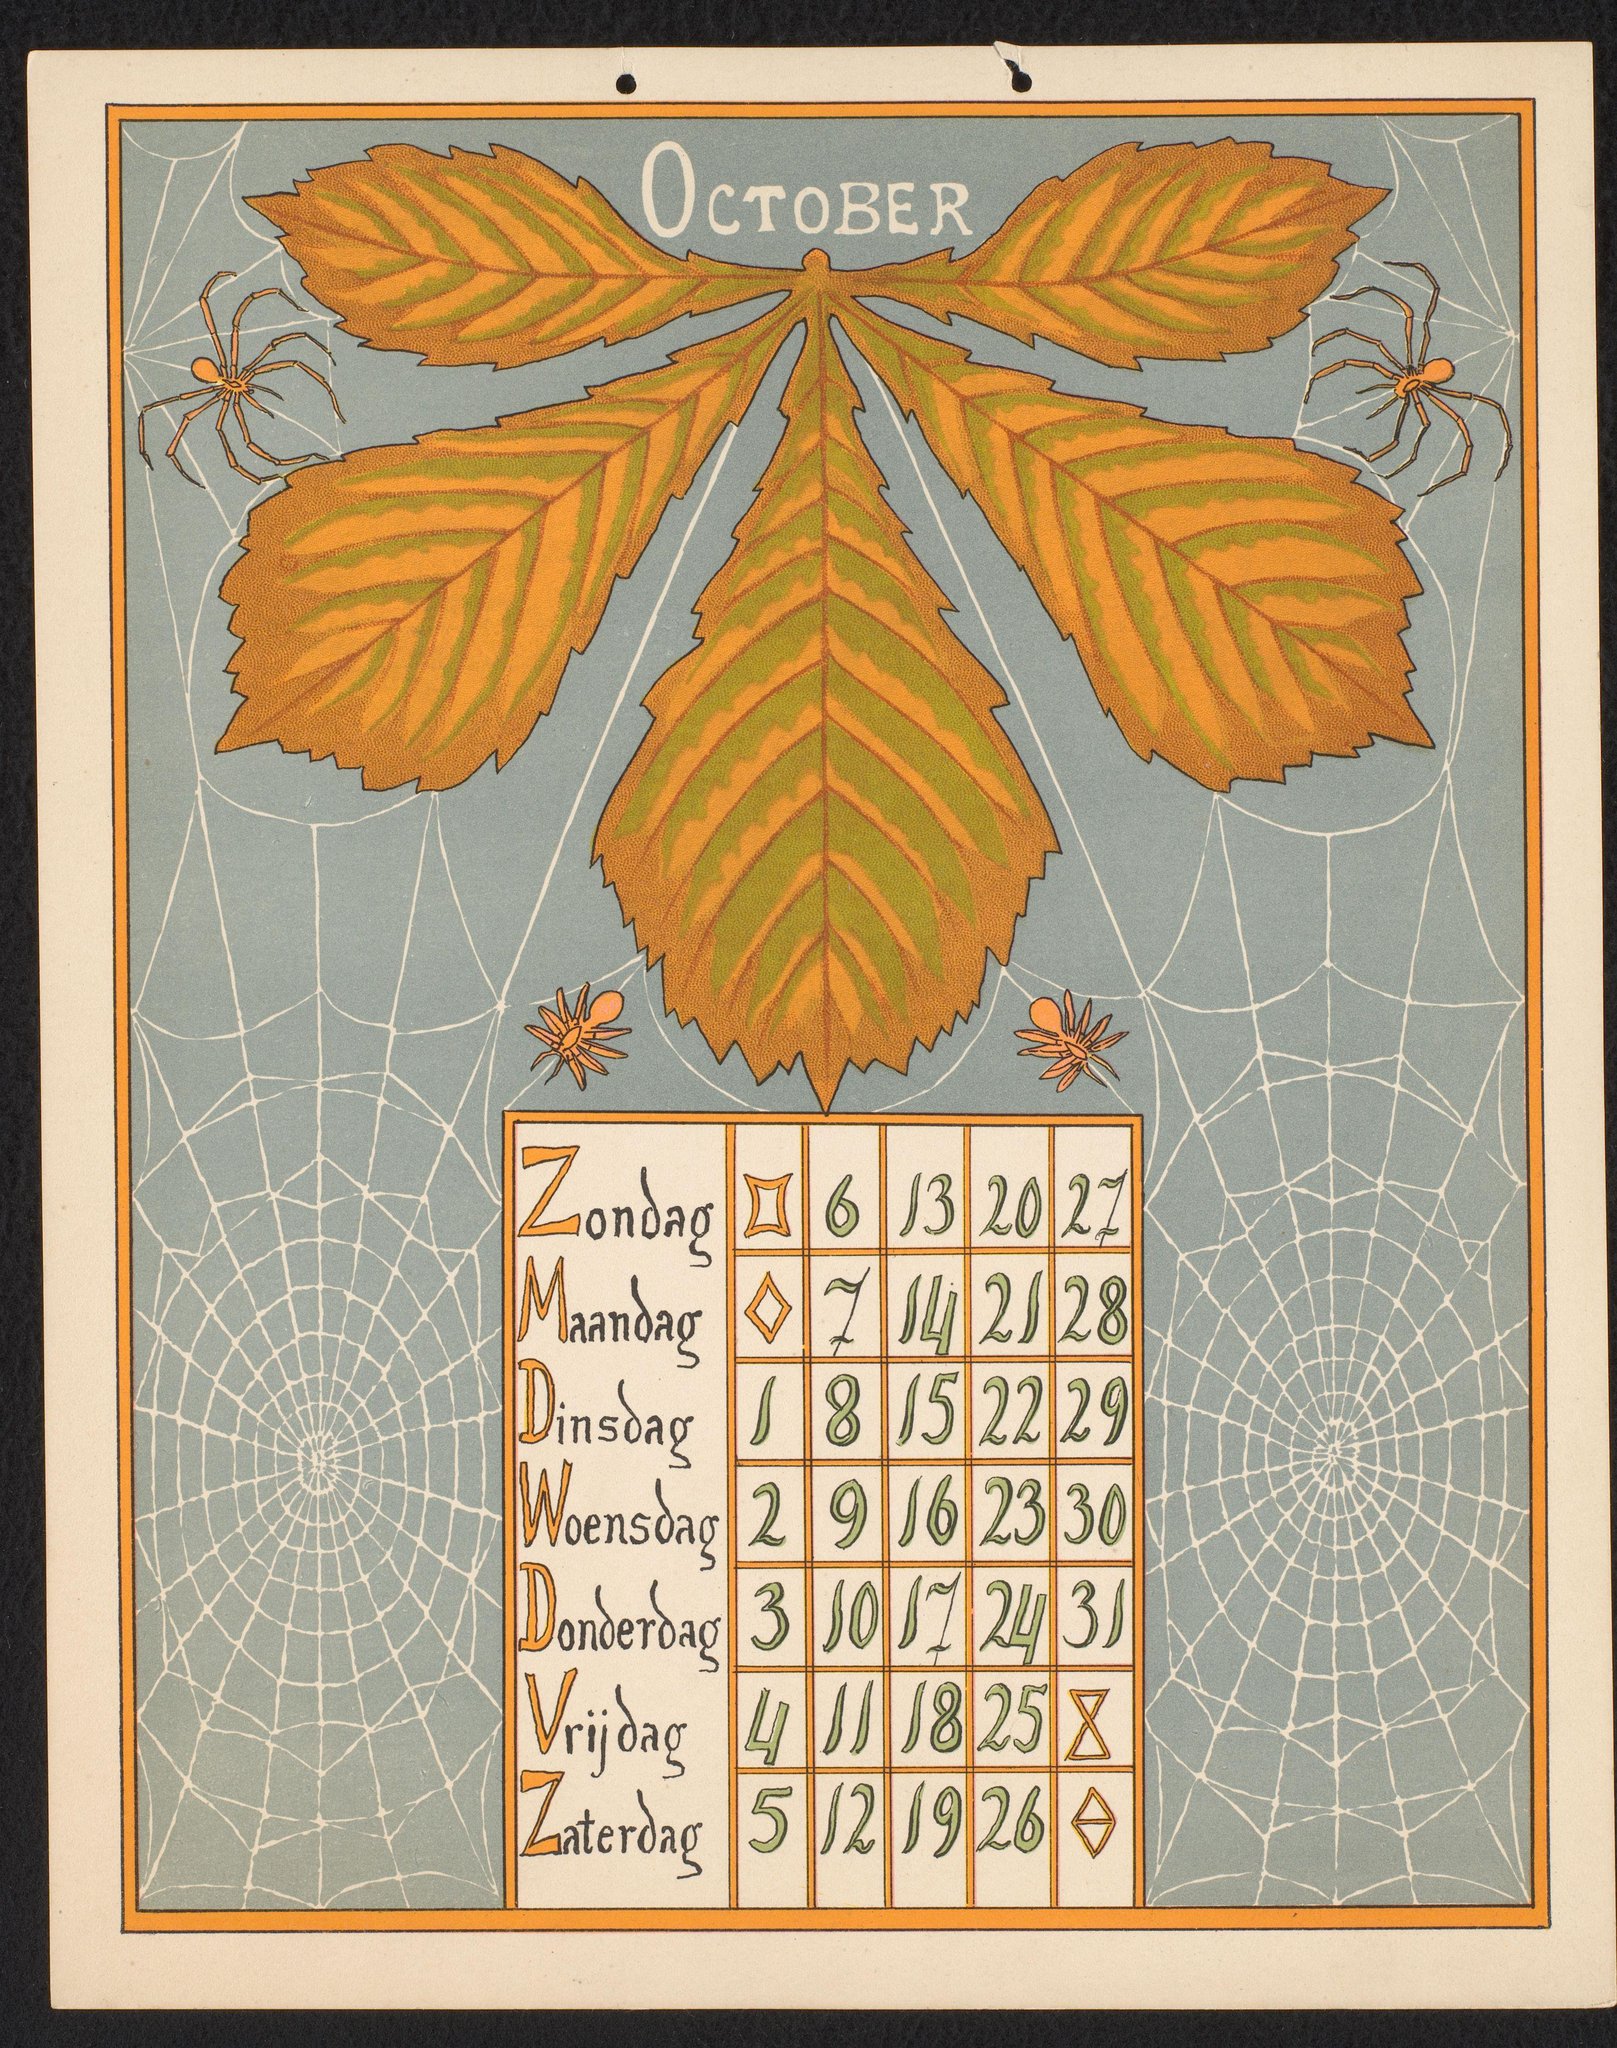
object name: calendar leaf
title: Kalenderblad voor oktober 1901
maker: c.a.j. van dishoeck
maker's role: publisher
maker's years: 1863-1931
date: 1900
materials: paper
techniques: lithograph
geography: amsterdam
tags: ornaments ~ art, calendar, almanac, spiders, fruits: chestnut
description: Kalenderblad voor oktober 1901 van de kalender 'Bloem en Blad', met een randdecoratie van spinnen, spinnenweb en kastanjeblad.